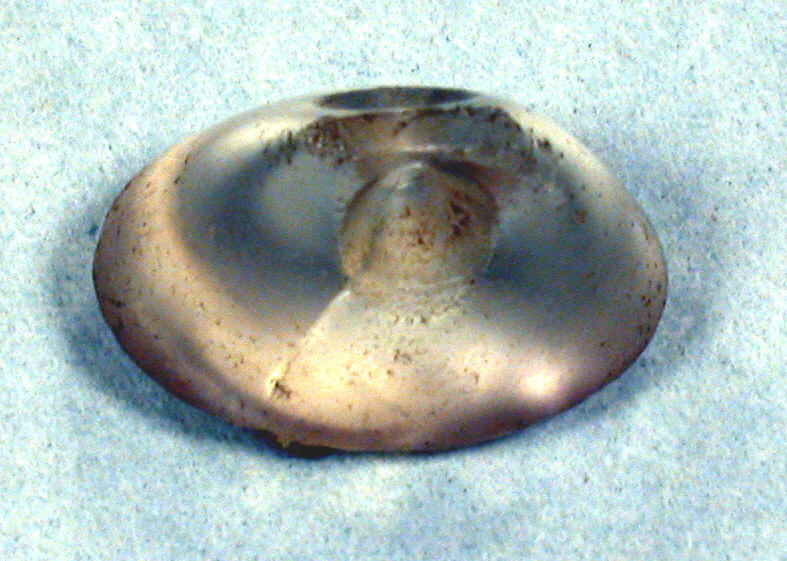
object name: pendant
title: Stone Pendant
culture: mexican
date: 1501-1600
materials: quartz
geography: mexico